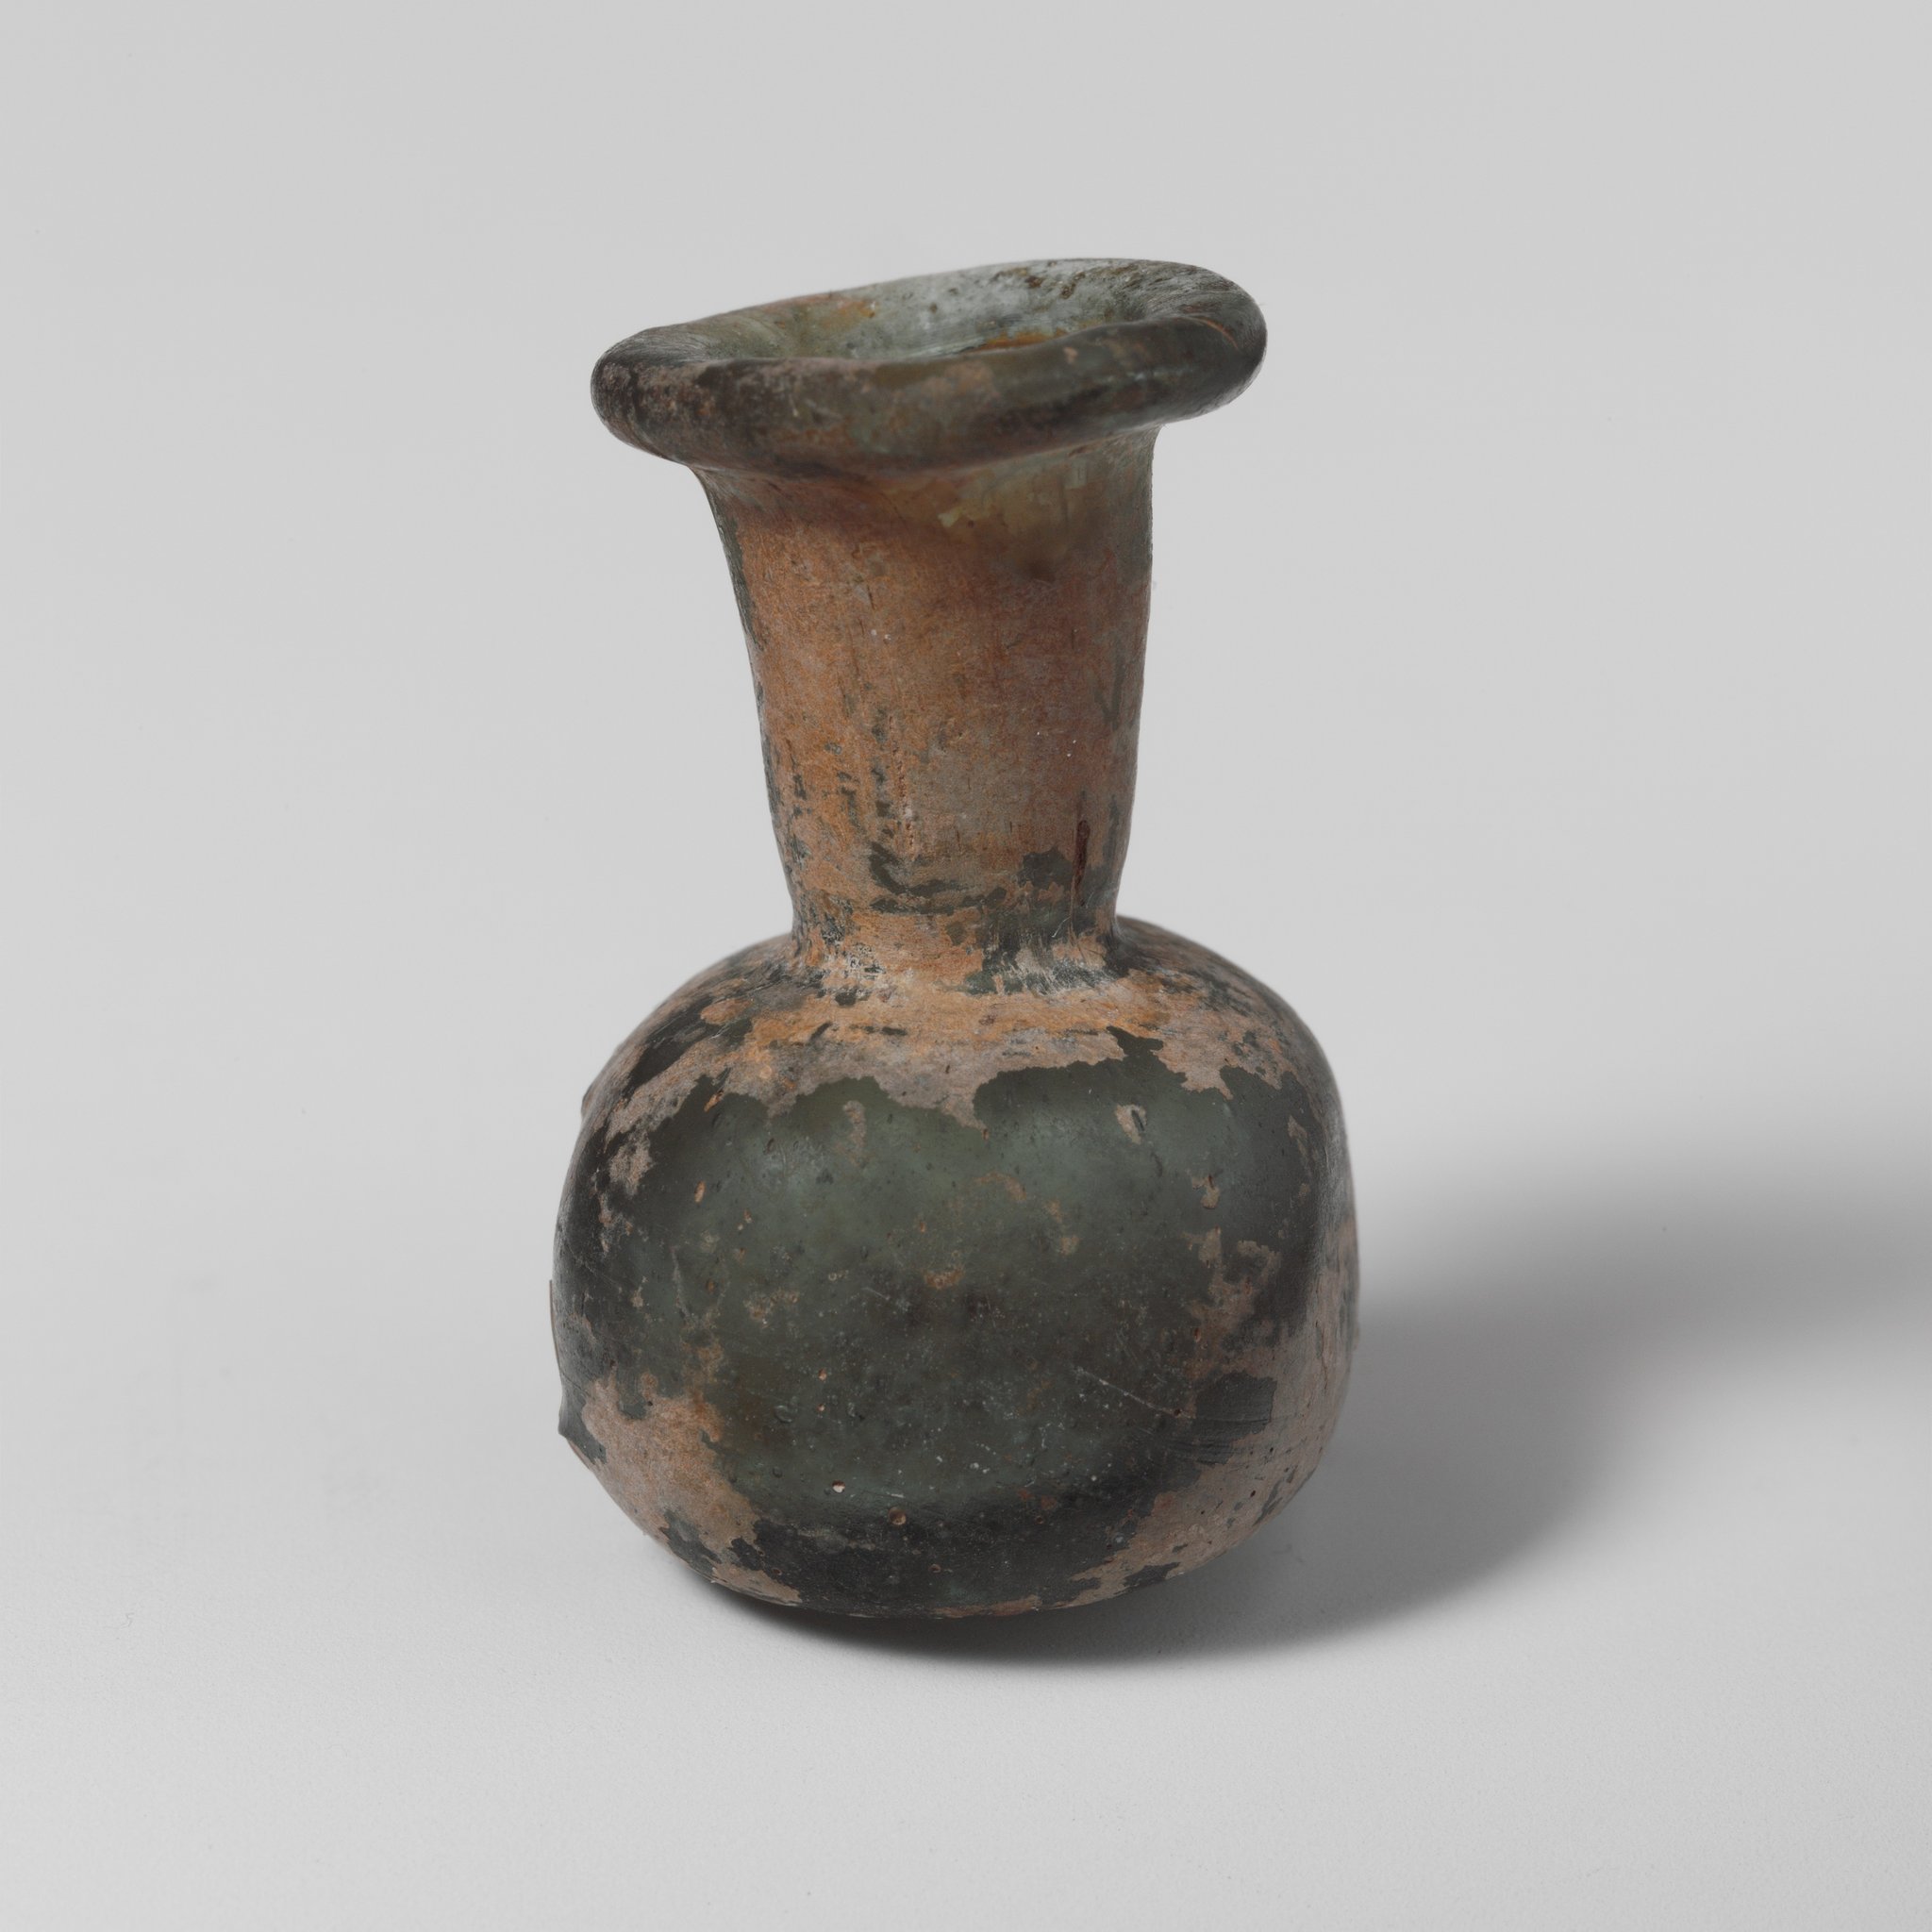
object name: perfume bottle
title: Glass perfume bottle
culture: roman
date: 101-300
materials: glass